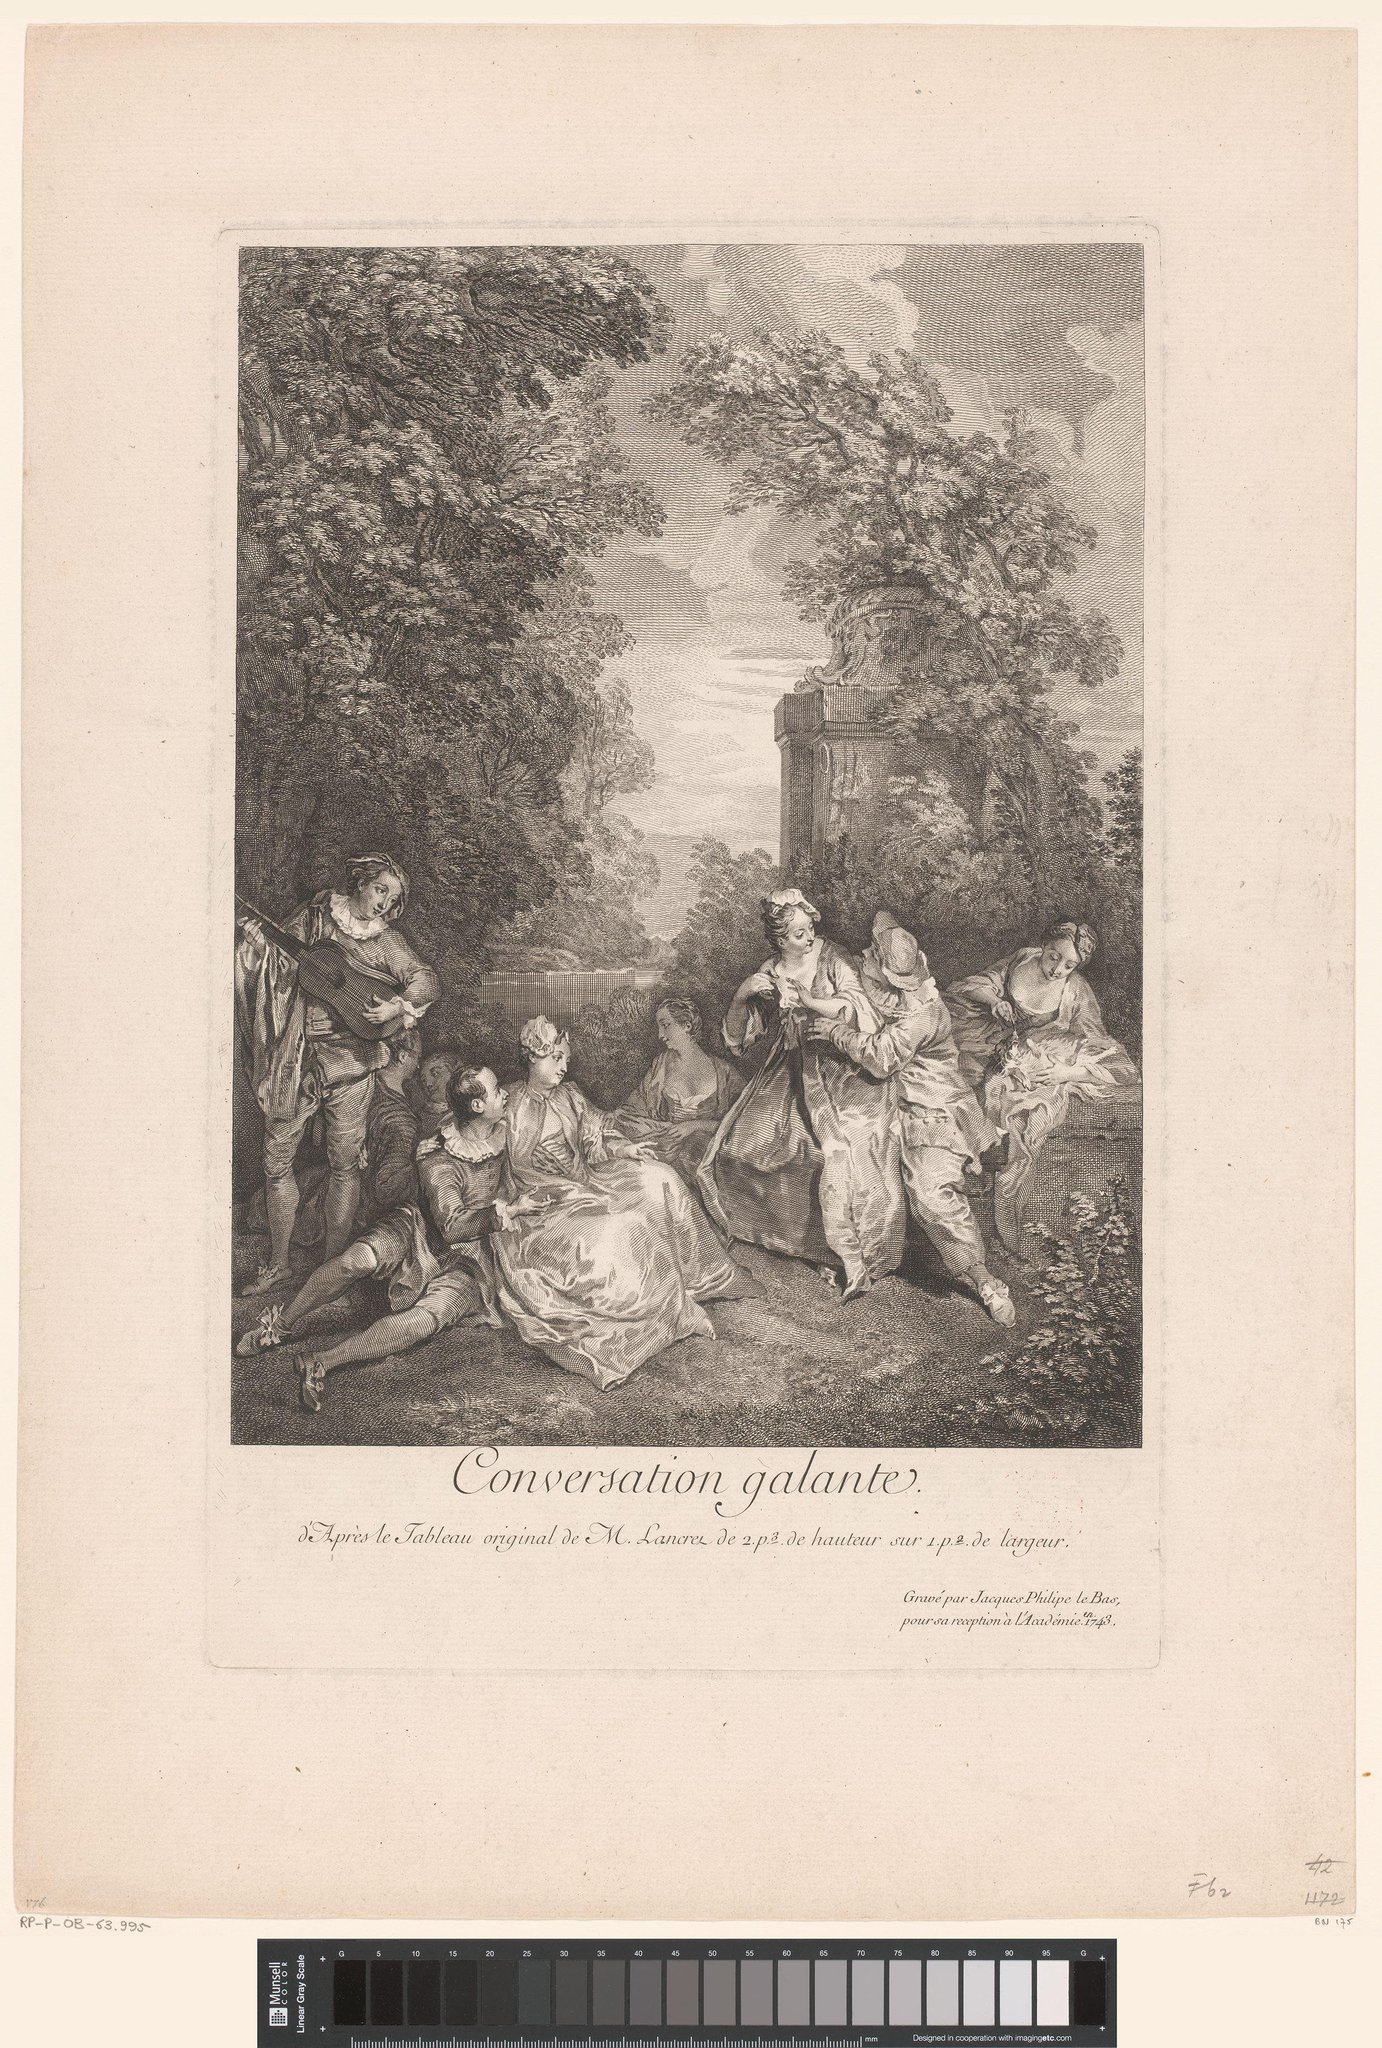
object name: print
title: Elegant gezelschap in een tuin (Fête Galante)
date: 1743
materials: paper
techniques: engraving, etching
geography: france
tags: garden, garden of love, court of love, 'fête galante'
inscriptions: collector's mark: Lugt 240